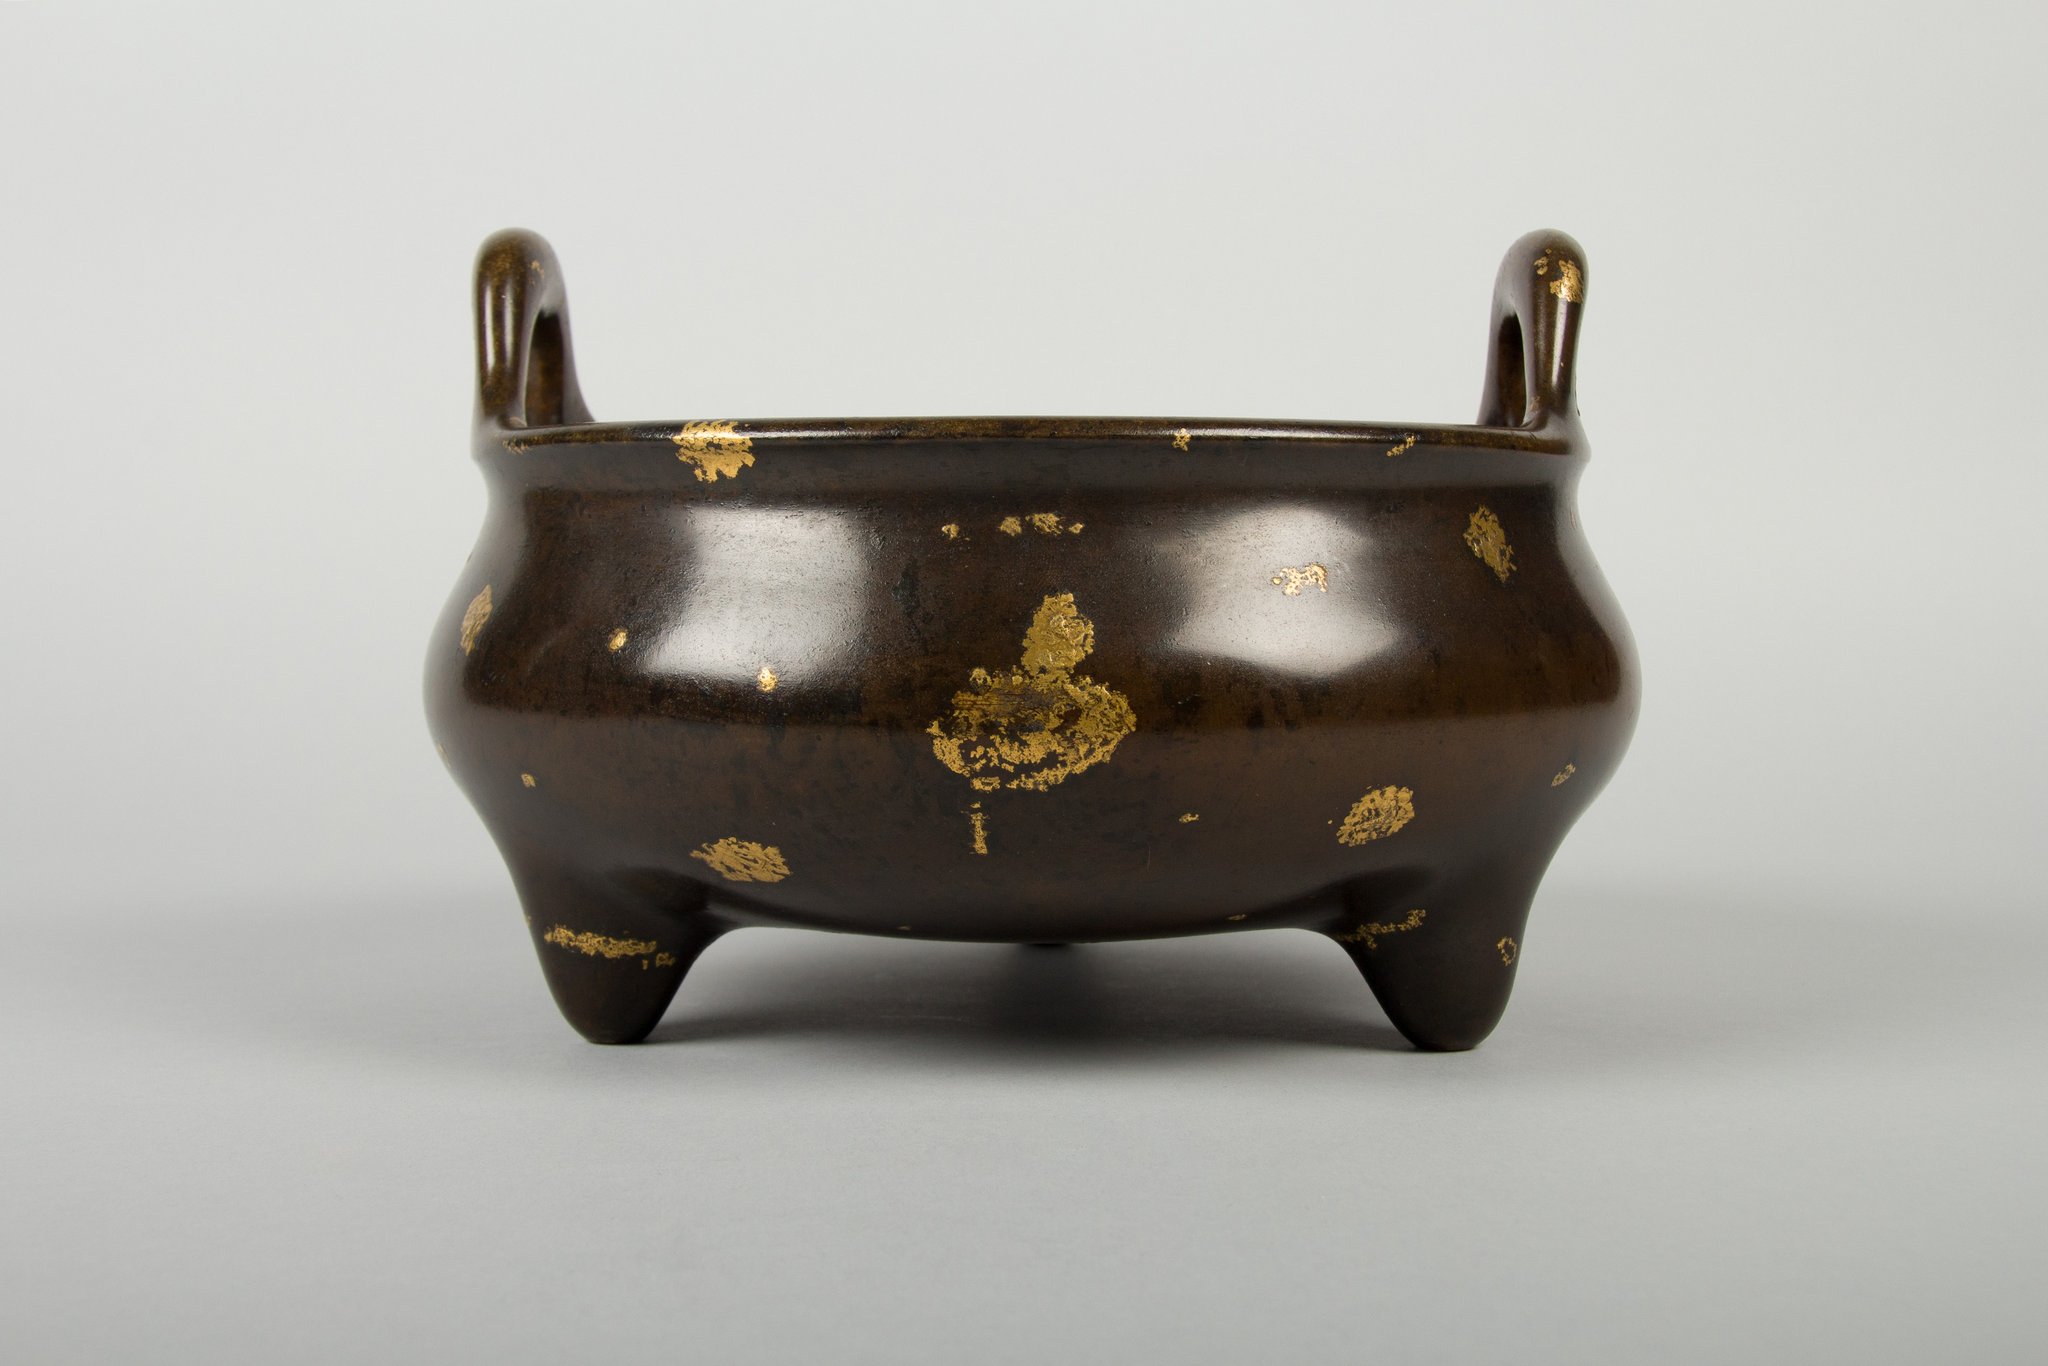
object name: incense burner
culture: chinese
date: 1701-1800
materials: copper alloy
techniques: gilding